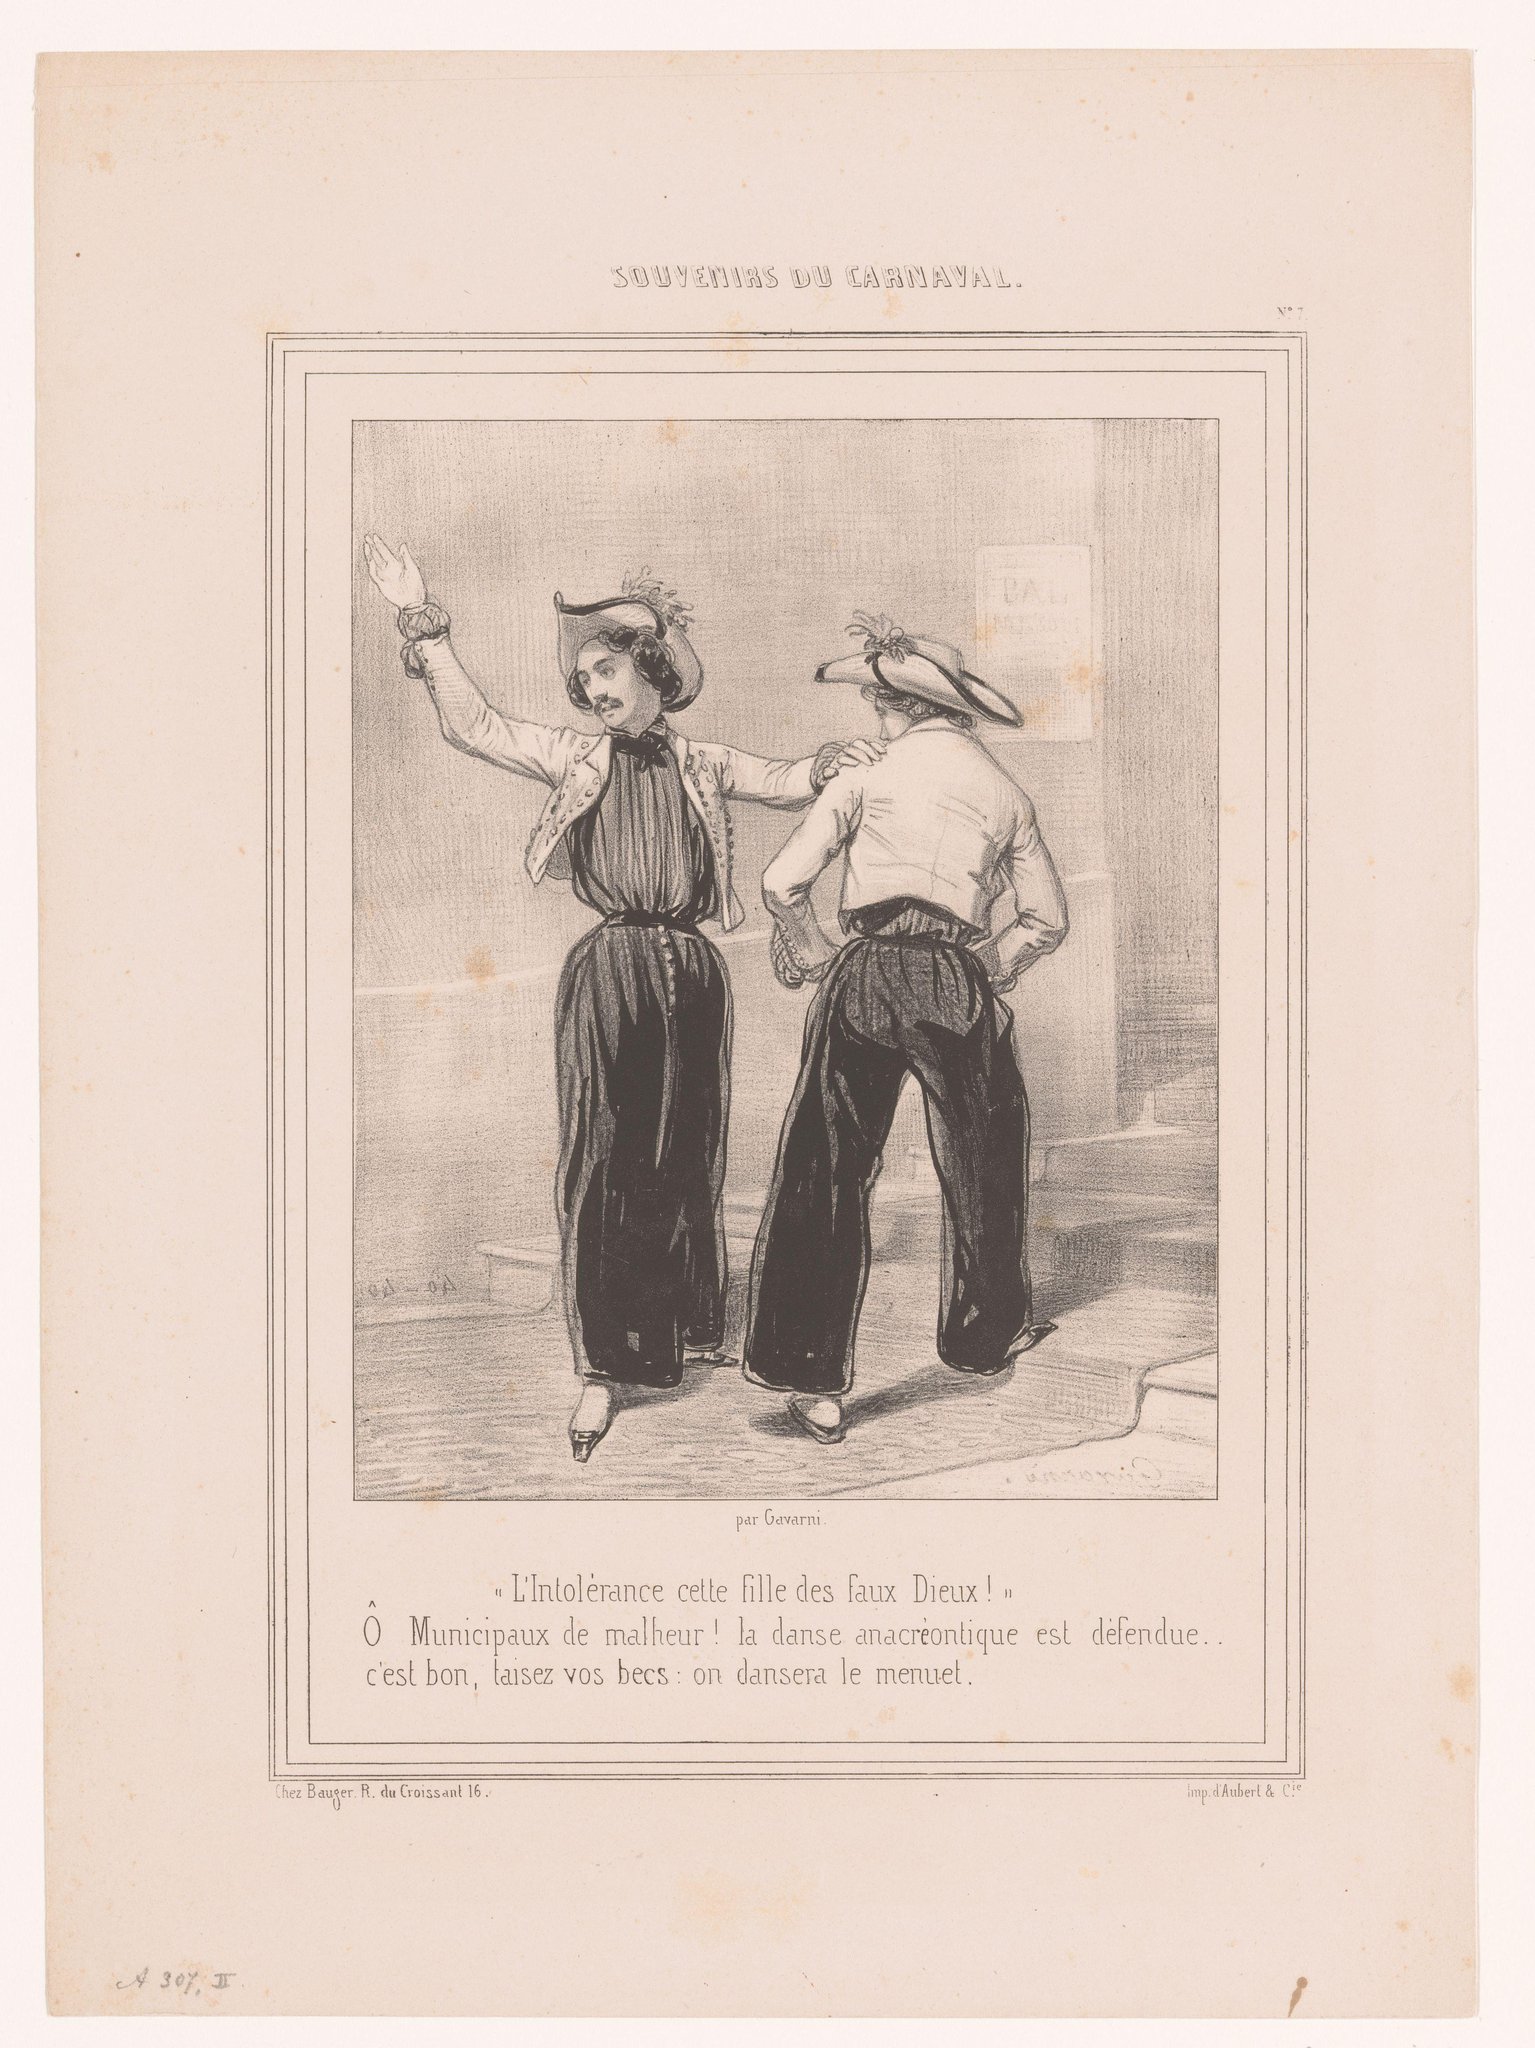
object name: cartoon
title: Souvenirs du carnaval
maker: paul gavarni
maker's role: draughtsman, print maker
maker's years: 1804-1866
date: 1840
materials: paper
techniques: lithograph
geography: paris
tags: festivities (+ costume party ~ festive activities), masquerade, masked ball, carnival, shrovetide (non-liturgical celebration)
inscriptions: collector's mark: Lugt 964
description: Prent gebruikt voor: La Caricature, 3 mei 1840, en voor: Le Charivari, 17 november 1841.